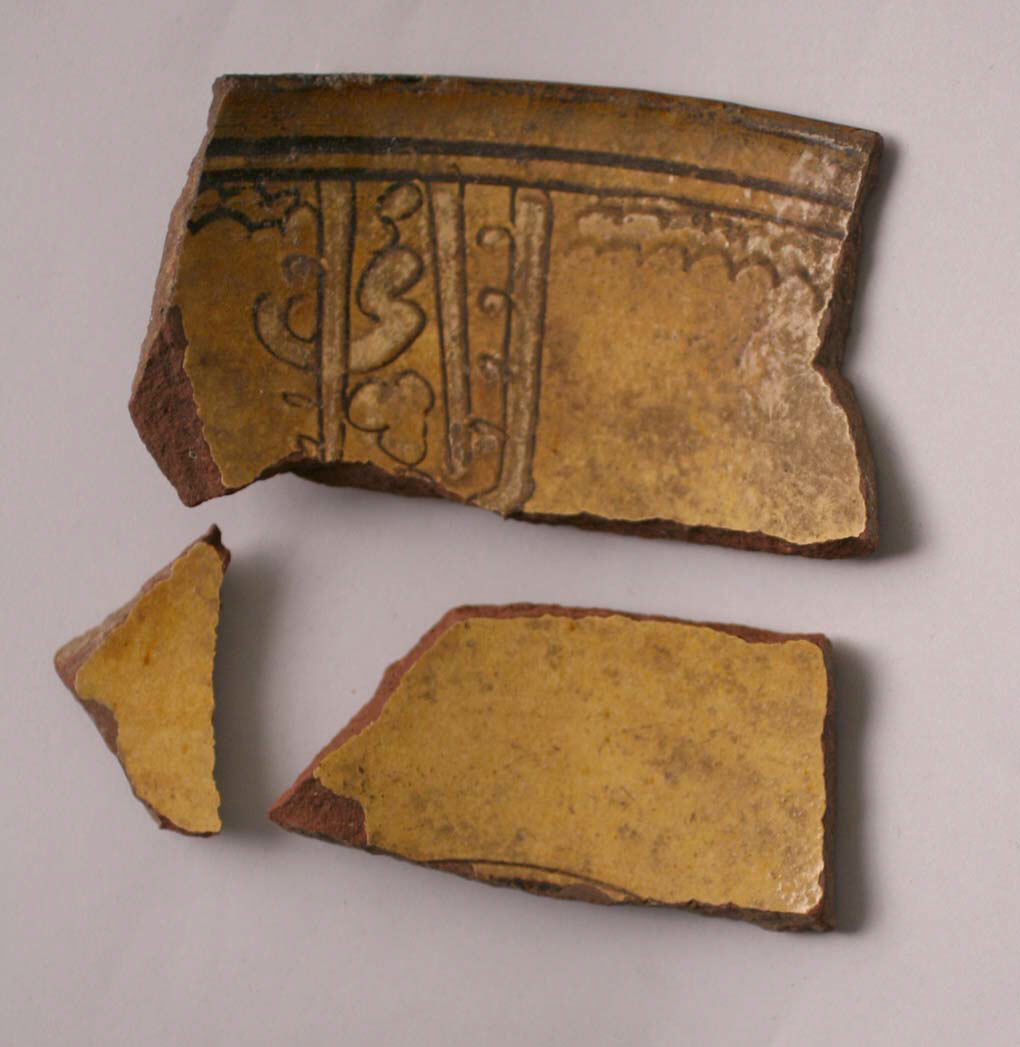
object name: fragment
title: Fragments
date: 1301-1500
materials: earthenware, glaze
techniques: coloring, incising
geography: egypt